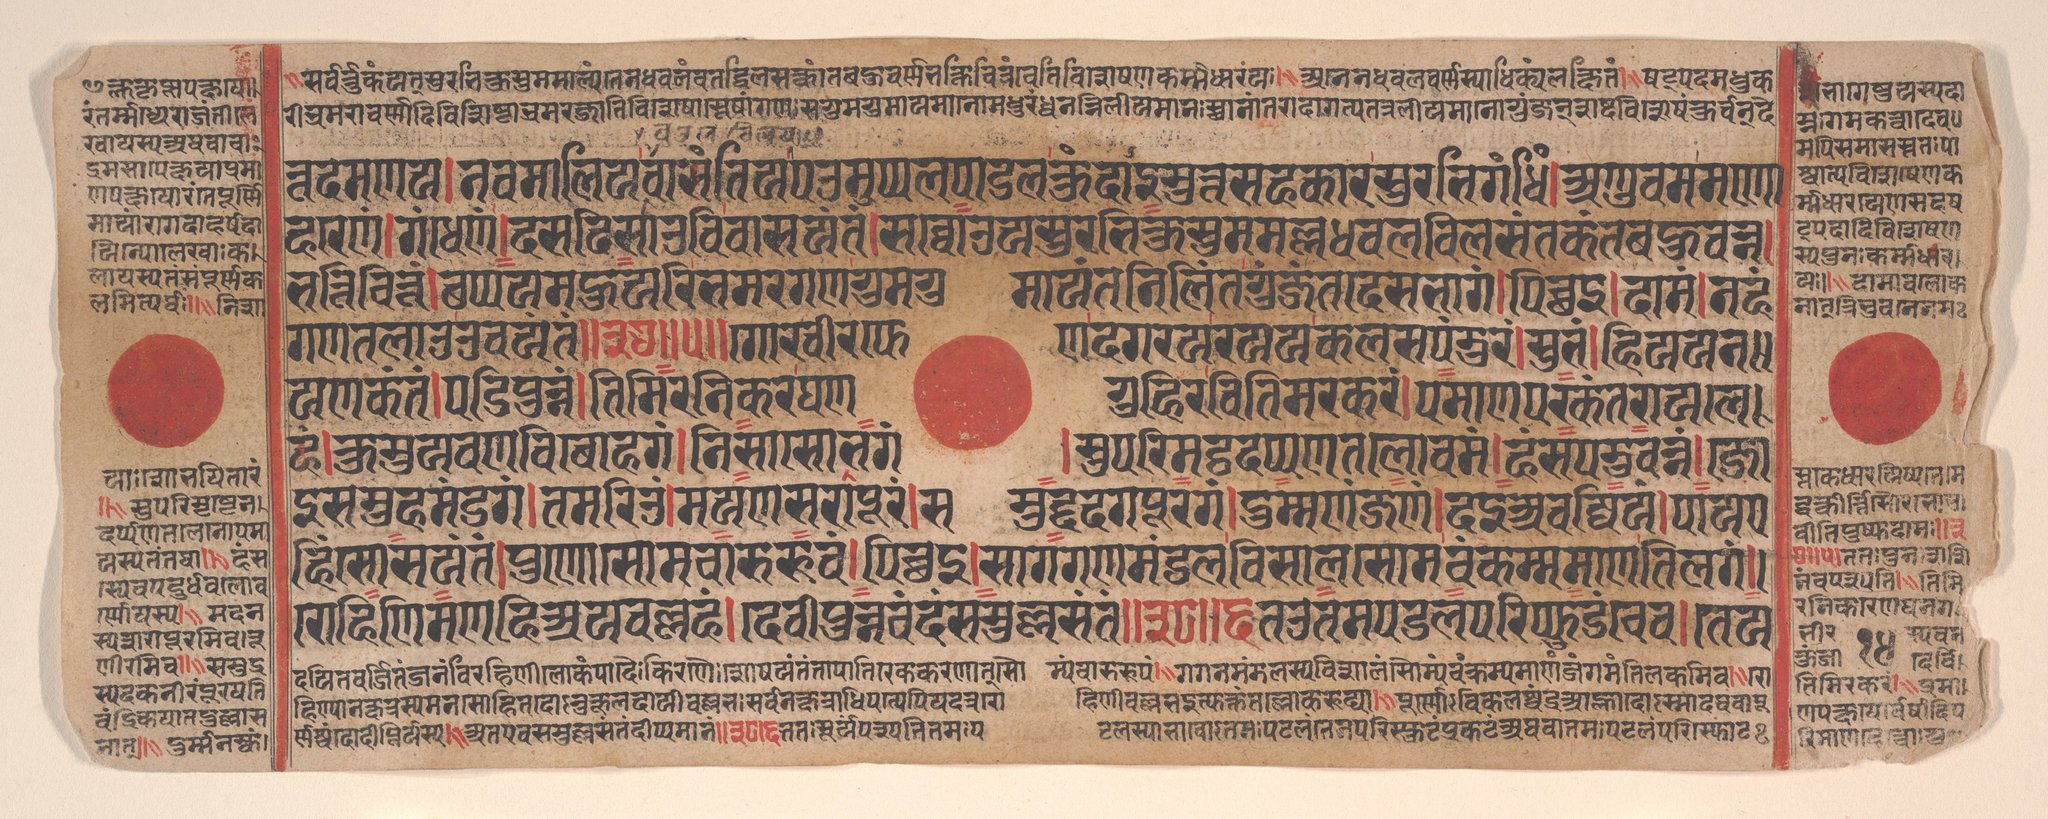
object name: folio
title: Leaf from a Kalpa Sutra (Jain Book of Rituals)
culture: indian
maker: bhadrabahu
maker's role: artist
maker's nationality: indian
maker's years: 356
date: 1401-1500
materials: gold, ink, paper, watercolor